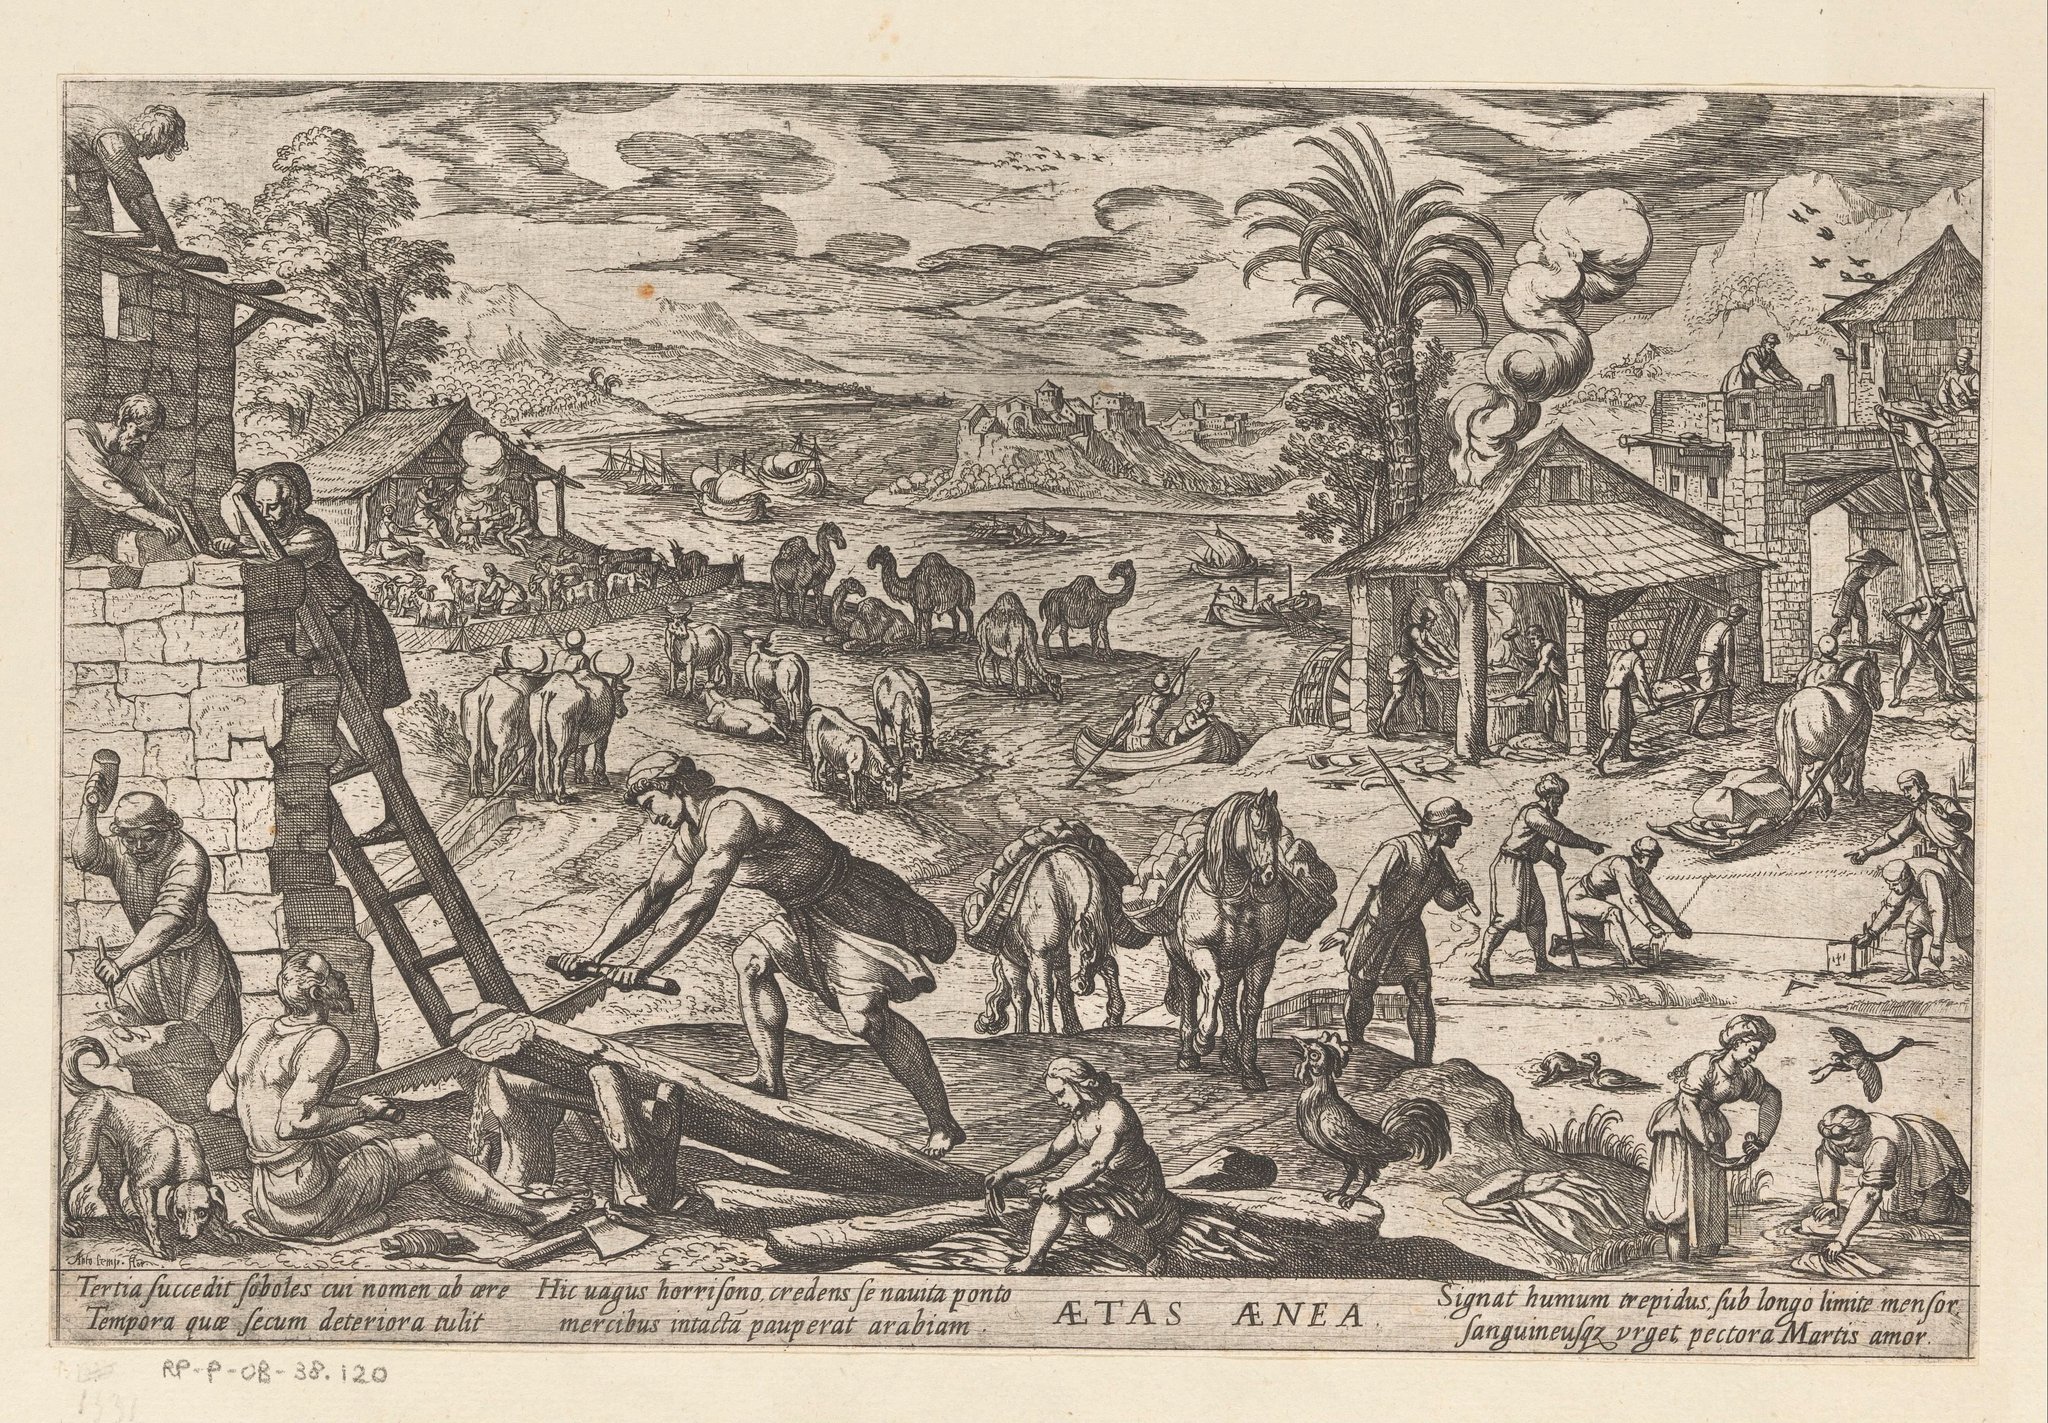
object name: print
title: Vier tijdperken van de wereld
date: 1599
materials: paper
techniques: etching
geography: rome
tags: the bronze age, 'aetas aenea'; characterized by minerva and building activities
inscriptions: collector's mark: Lugt 240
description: Het bronzen tijdperk: landschap met mensen en bouwactiviteiten. Links wordt een huis gebouwd. In het midden worden materialen aangedragen en wordt er gezaagd. Onderschrift en titel in het Latijn in ondermarge.